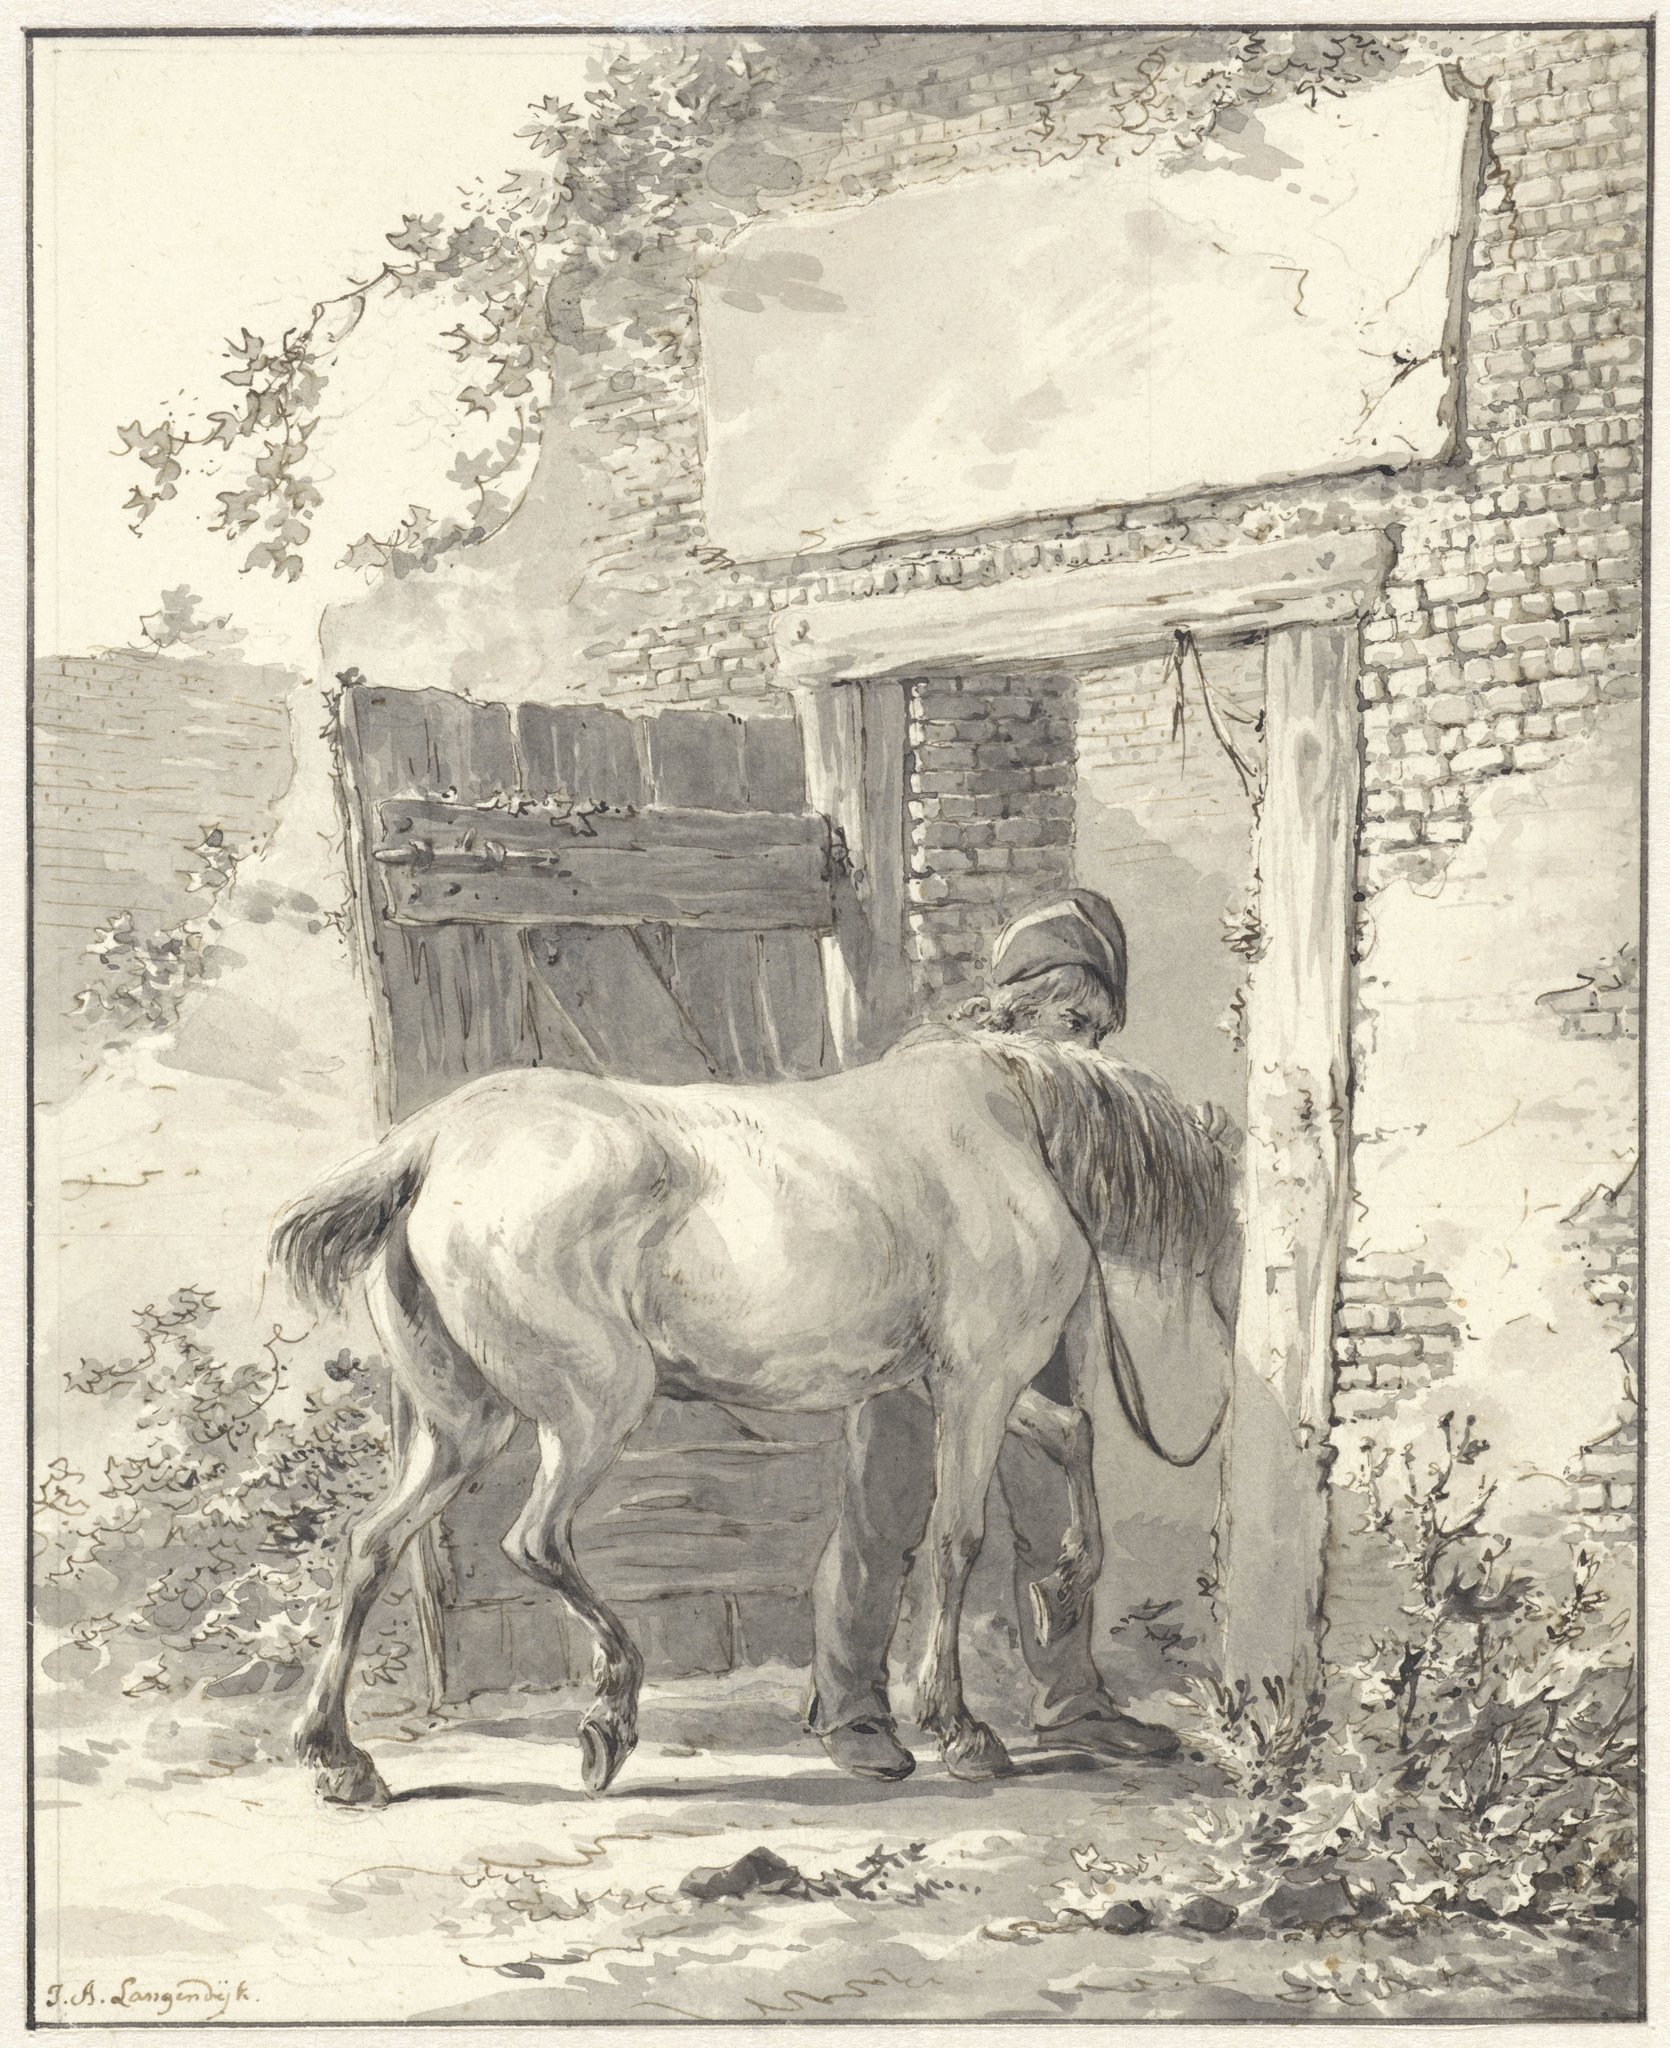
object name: design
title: Stalknecht een paard de stal binnenleidend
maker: jan anthonie langendijk dzn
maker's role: draughtsman, print maker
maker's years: 1780-1818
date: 1790-1818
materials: ink, paper, pencil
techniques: brush, pen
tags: horse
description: Stalknecht een paard bij de toom de stal binnenleidend. Ontwerp voor een prent.